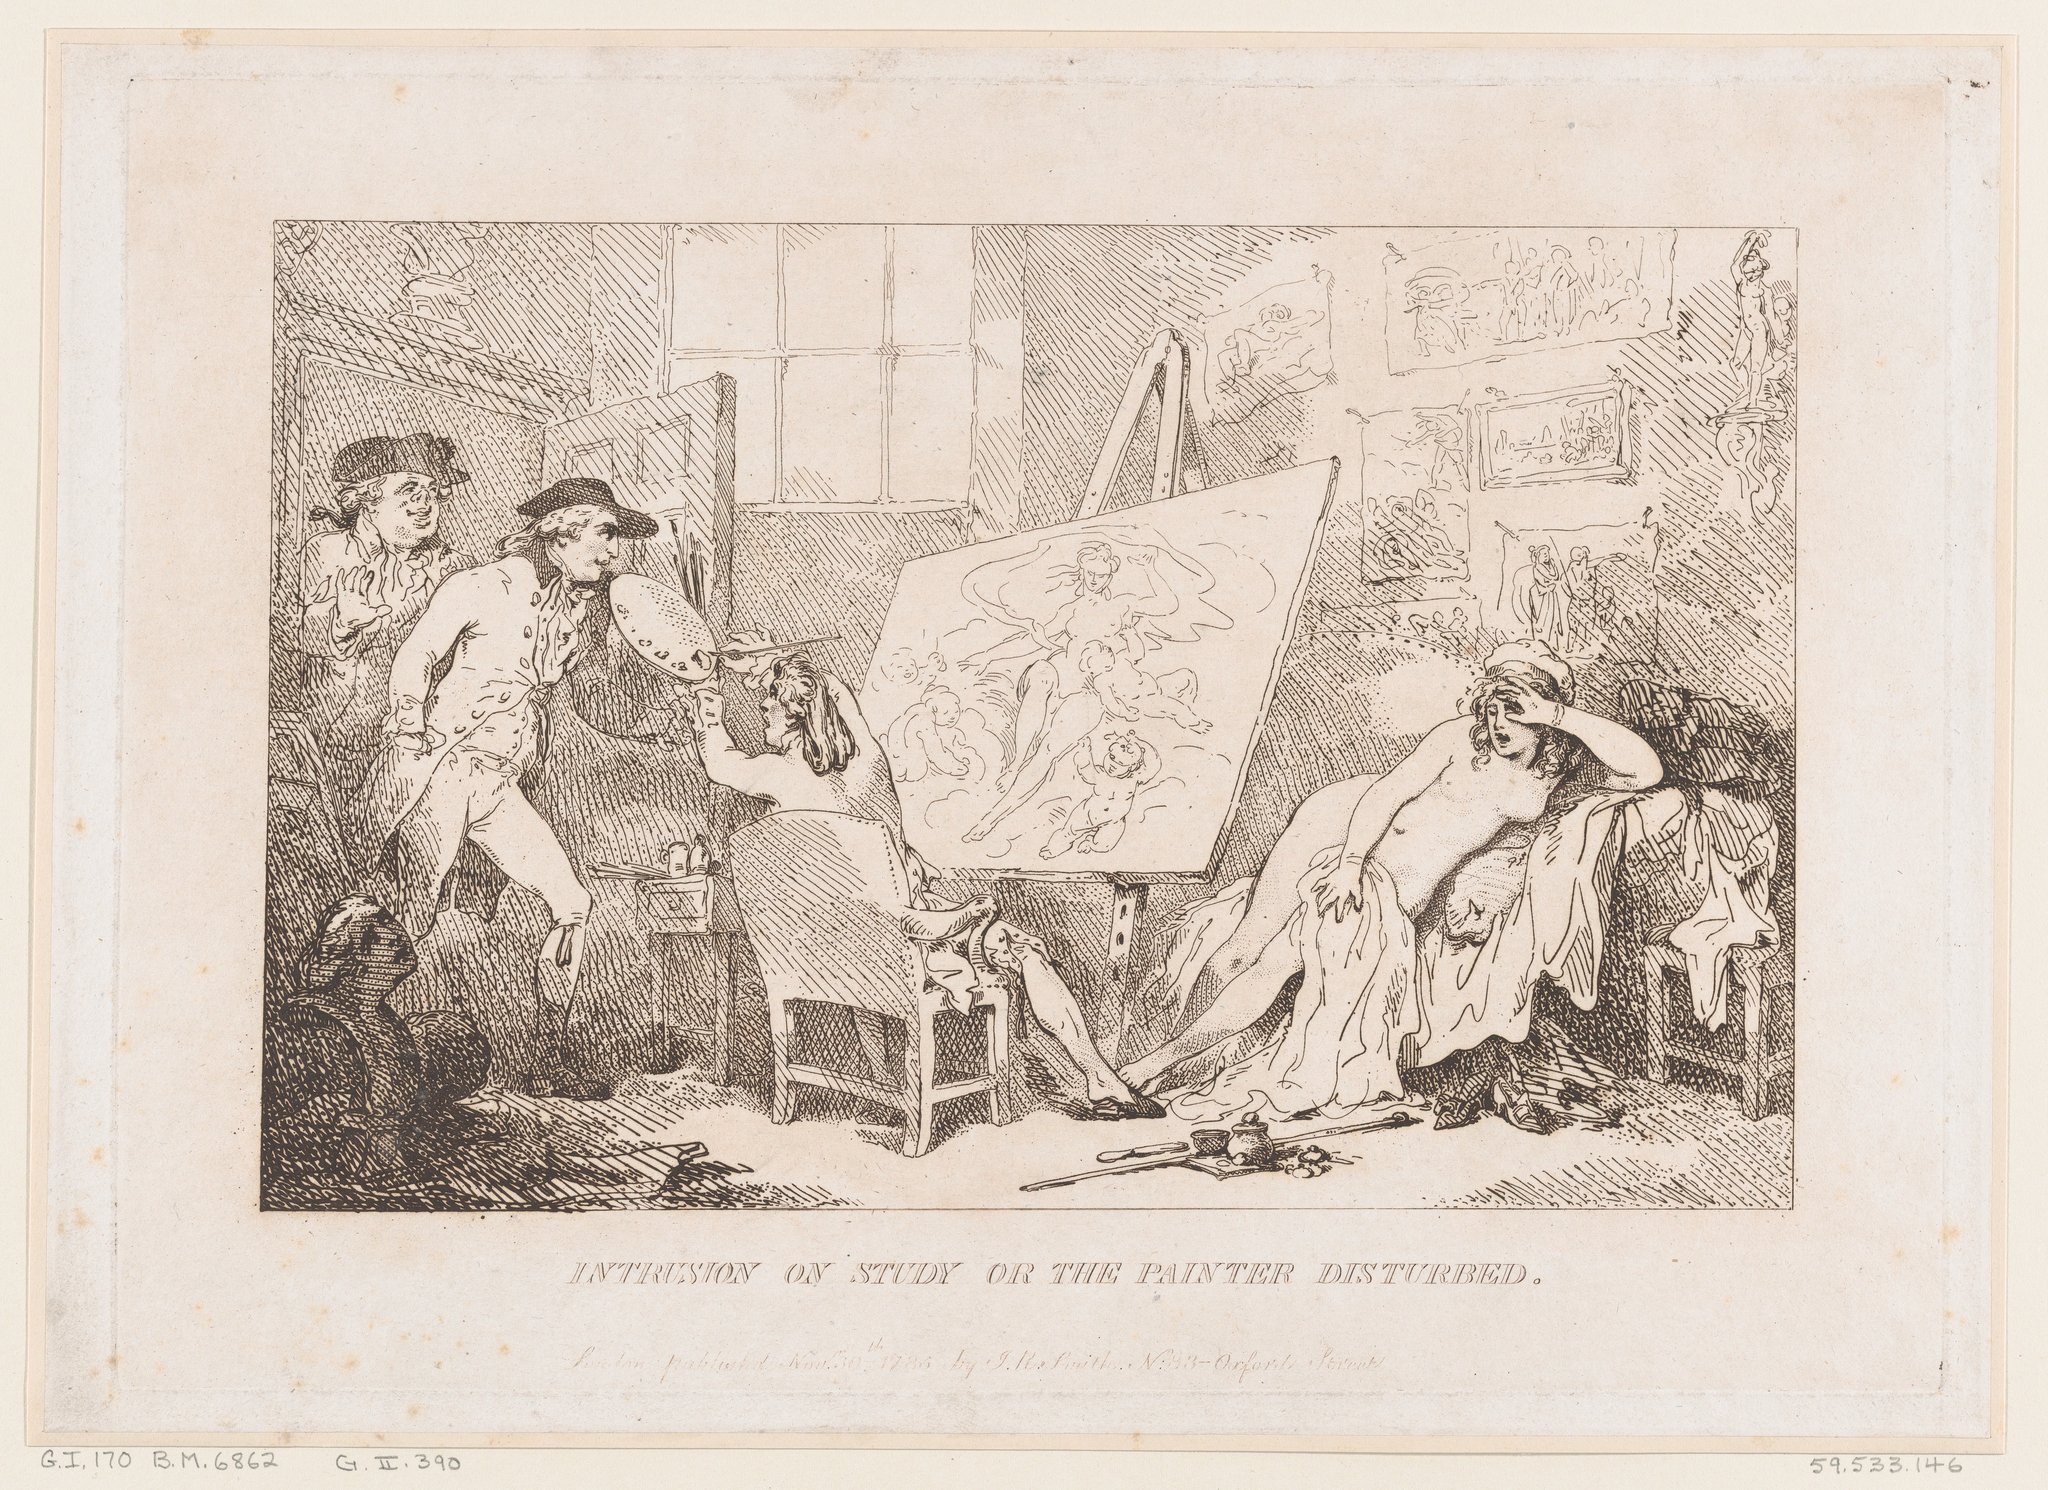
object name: print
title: Intrusion on Study or The Painter Disturbed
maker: thomas rowlandson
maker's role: artist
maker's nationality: british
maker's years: 1757-1827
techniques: etching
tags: painting,men,female nudes,easels,palettes